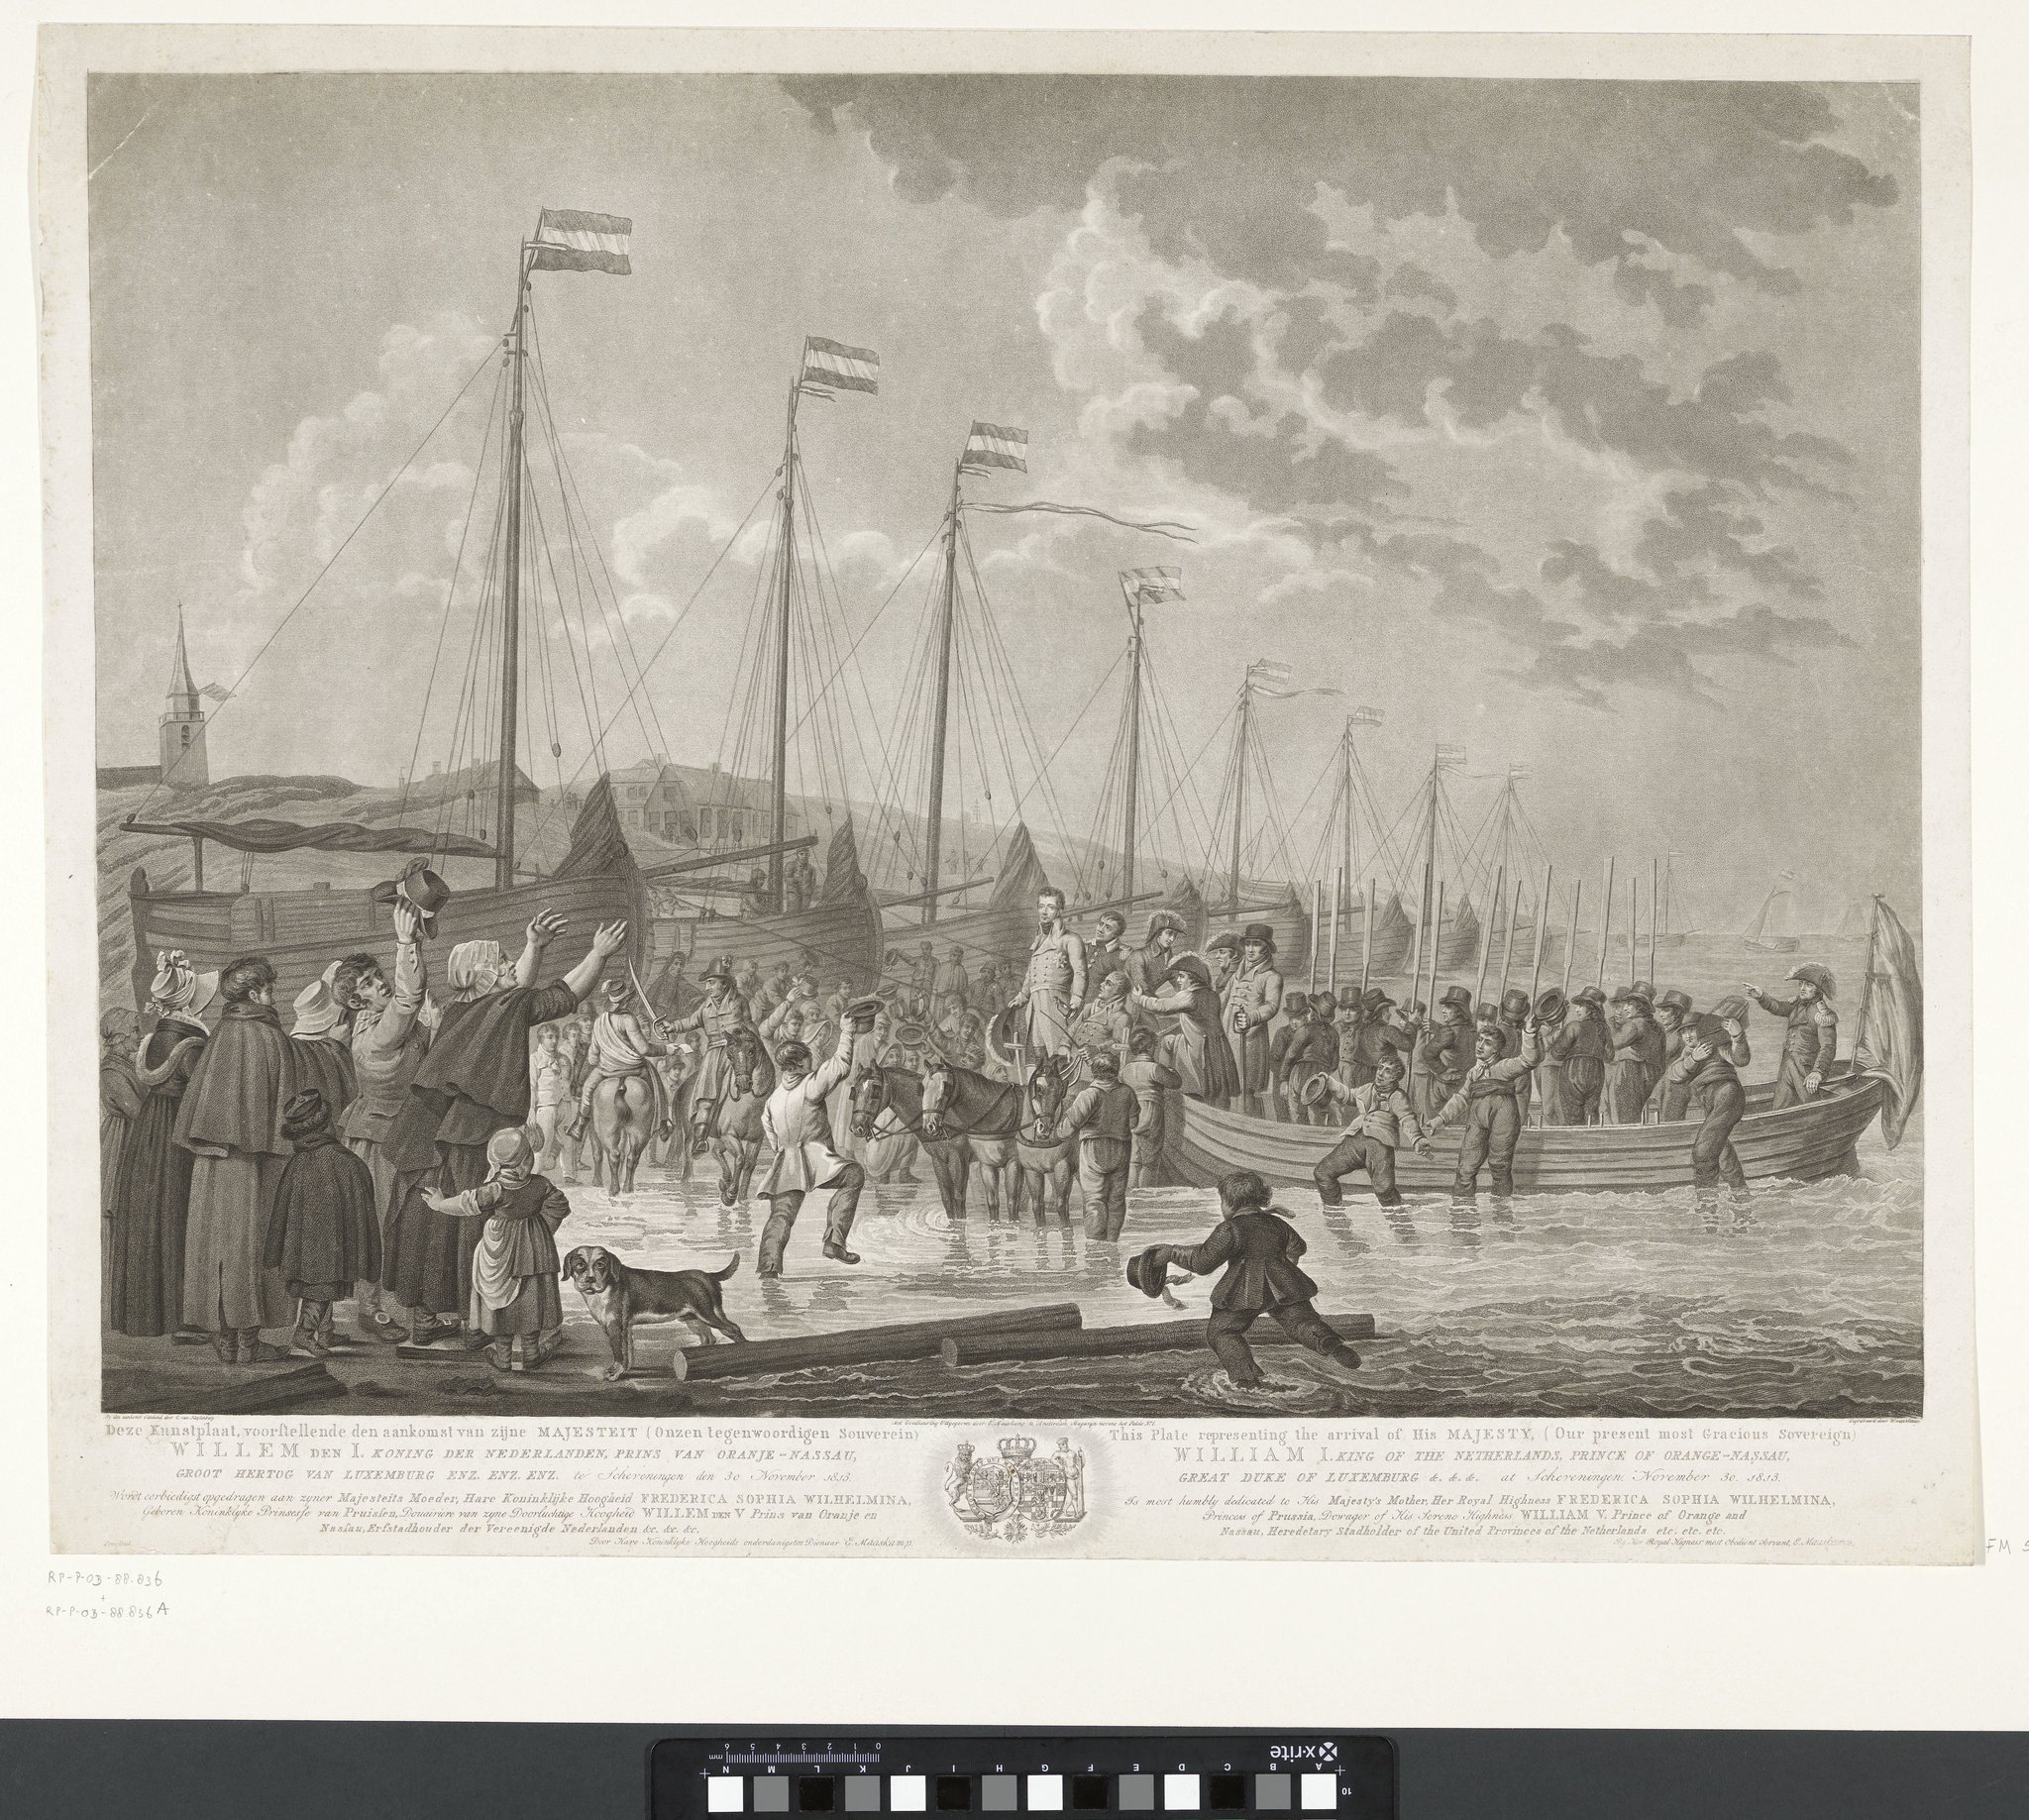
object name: print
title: Deze Kunstplaat, voorstellende den aankomst van zijne Majesteit (Onzen tegenwoordigen Souverein) Willem den I. Koning der Nederlanden (...) te Scheveningen den 30 November 1813 / This plate representing the arrival of His Majesty, (Our present most Gracious Sovereign) (...)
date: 1814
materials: paper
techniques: aquatint, engraving, etching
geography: amsterdam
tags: berlin, william i of the netherlands, being welcomed ~ travelling, homage to a ruler, landing of william frederick i (1813)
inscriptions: collector's mark: Lugt 2228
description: Aankomst van prins Willem Frederik op het strand van Scheveningen, 30 november 1813, om als soeverein vorst de regering van het land op zich te nemen. De prins staande in de boerenwagen. Op het strand begroet een enthousiaste menigte de prins. Onderaan de titels in het Nederlands en Engels, gescheiden door de wapens van de prins en van Groot-Brittannië. Bij de prent behoort een afzonderlijke verklaring.